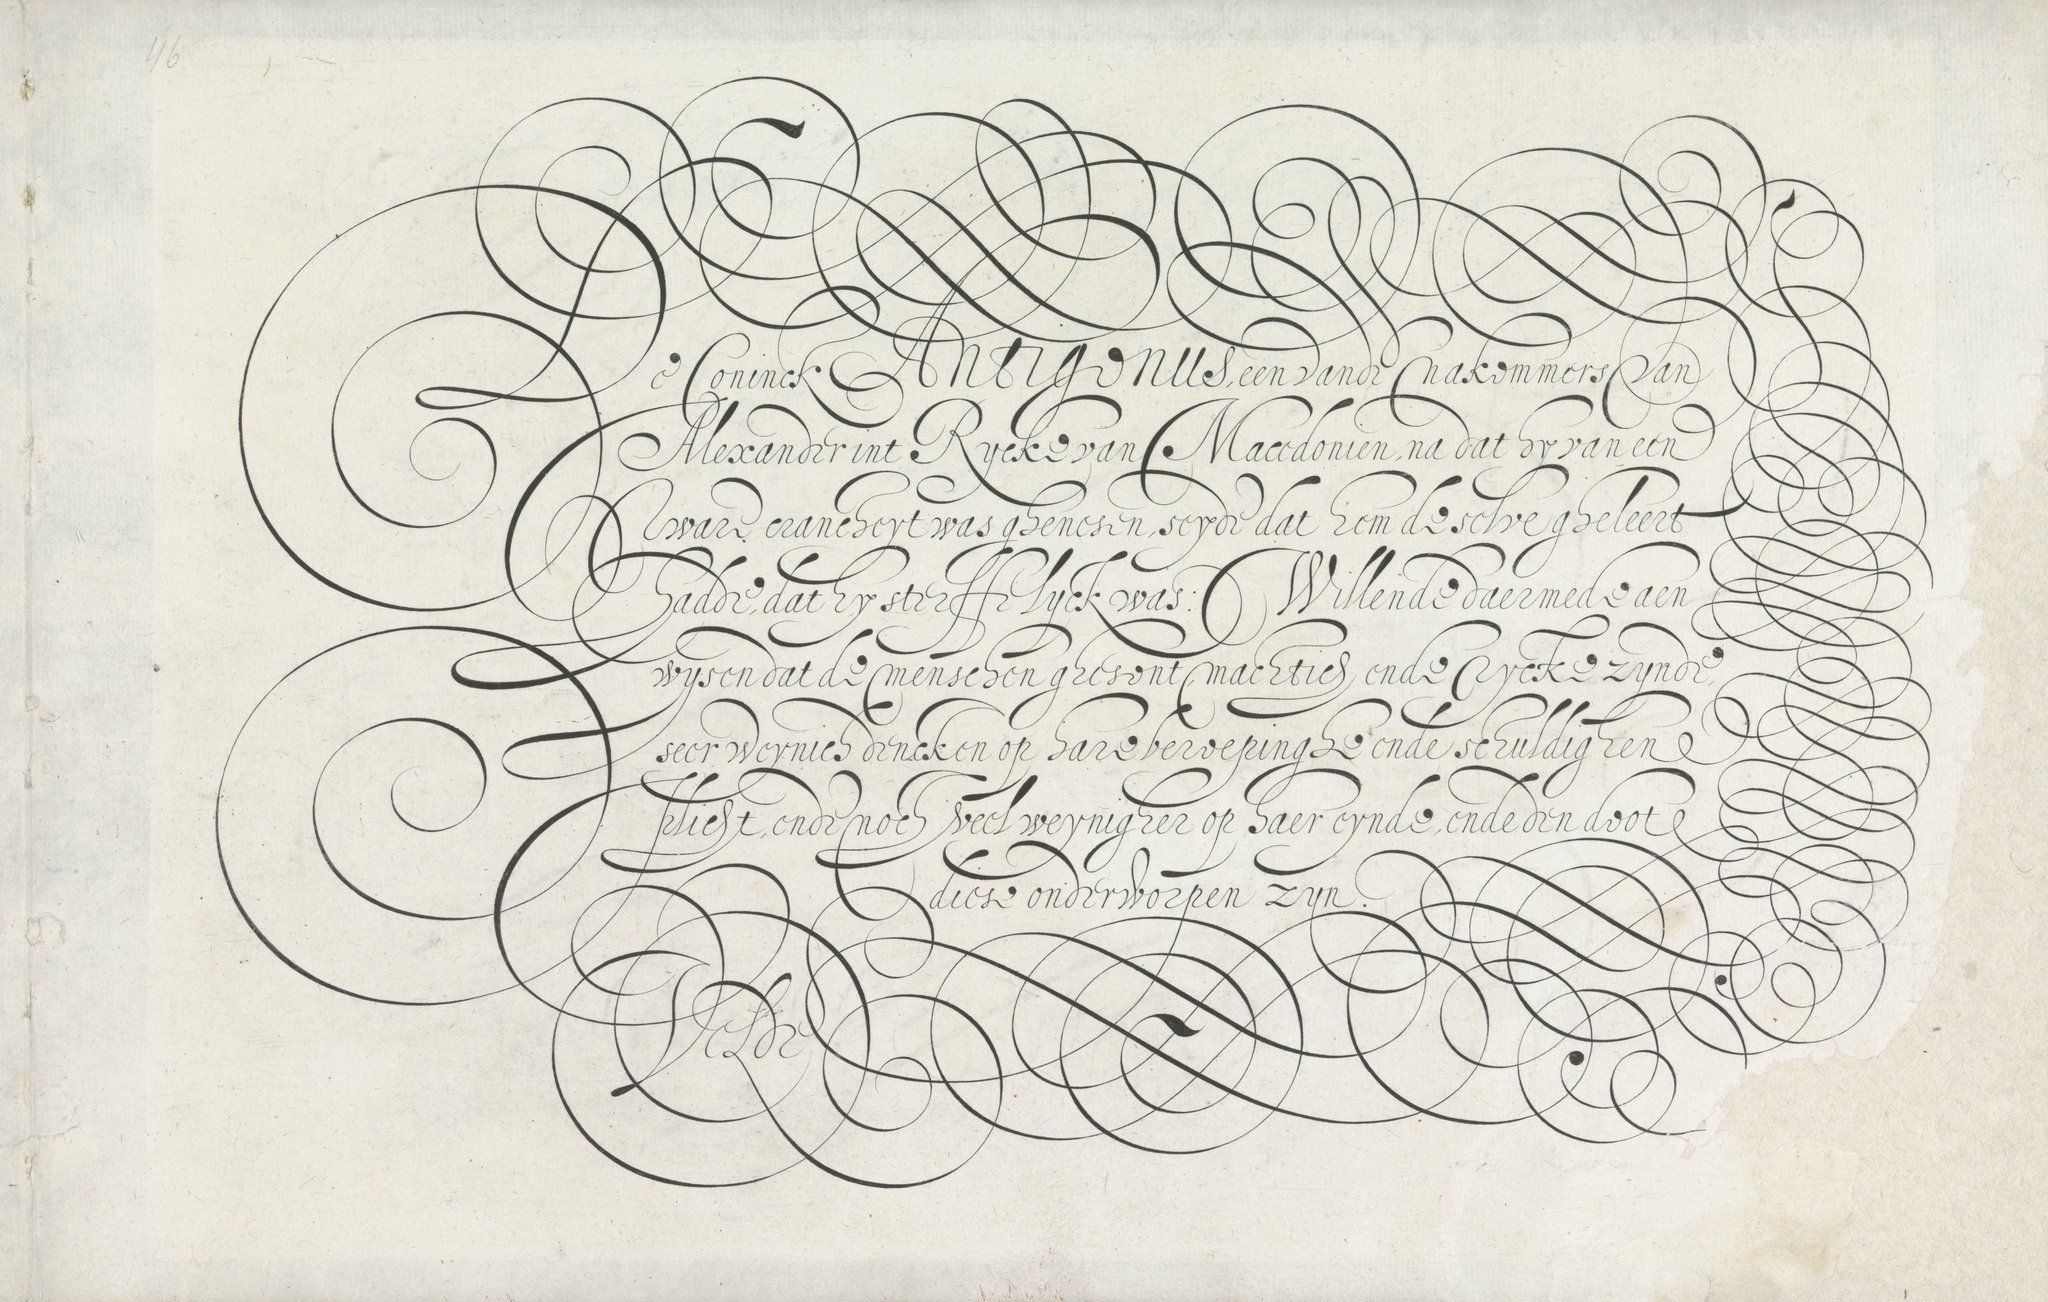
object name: album leaf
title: Spieghel der schrijfkonste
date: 1605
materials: paper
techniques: engraving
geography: rotterdam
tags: calligraphy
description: Schrijfvoorbeeld met acht regels tekst in het Nederlands: De coninck Antigonus ... De tekst is omlijst met krulwerk. De prent maakt deel uit van een album.